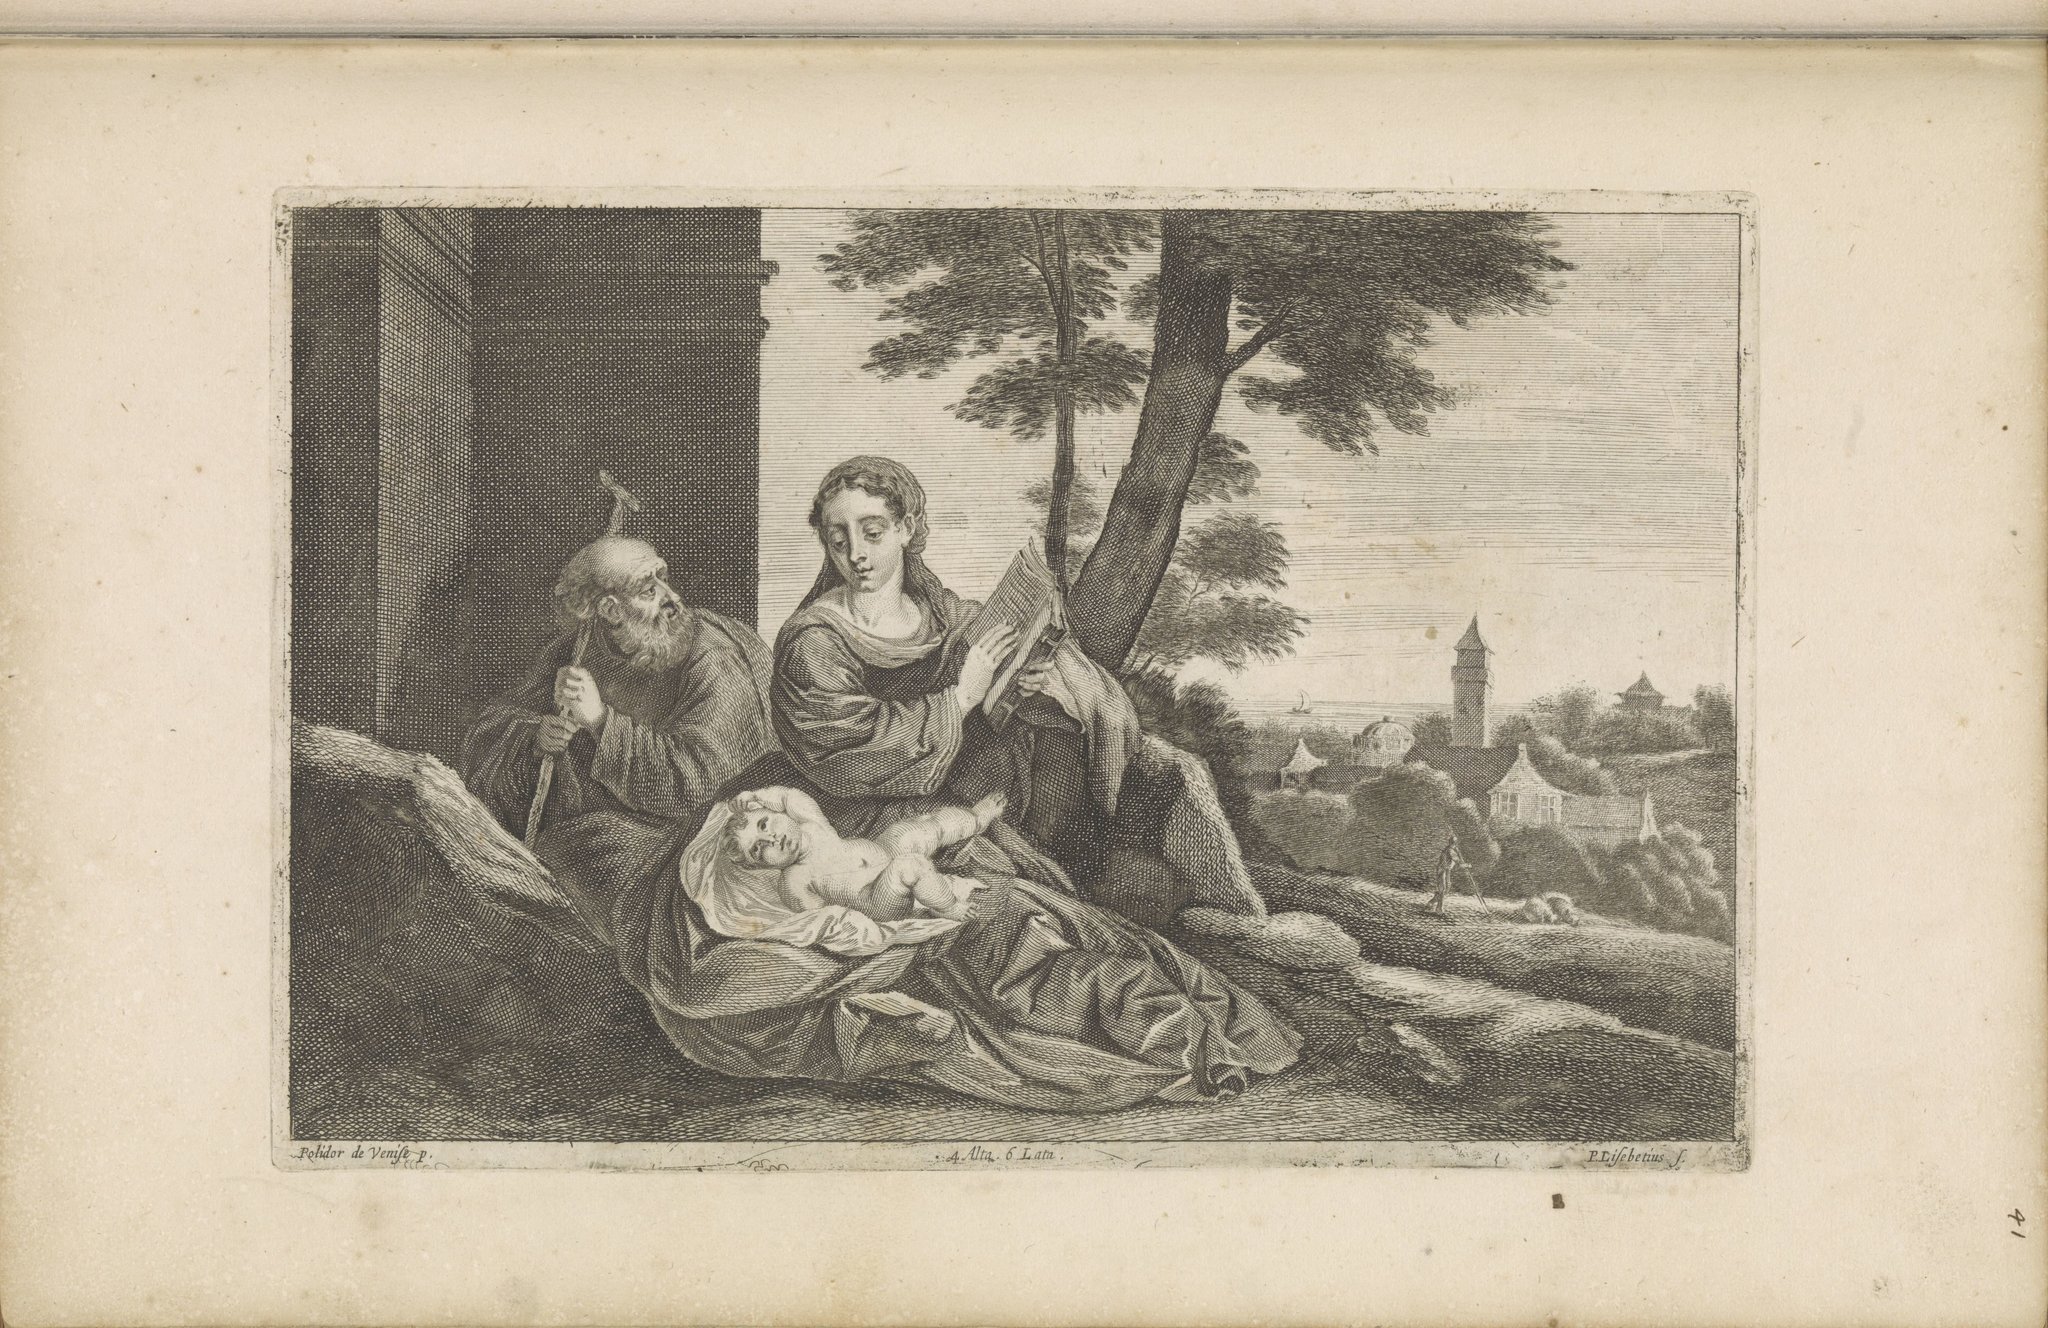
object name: album leaf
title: Heilige Familie in een landschap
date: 1660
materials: paper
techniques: engraving, etching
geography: venice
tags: reading, landscapes in the temperate zone, holy family (alone), 'trinitas terrestris'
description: David Teniers heeft waarschijnlijk van alle schilderijen uit de collectie van Leopold Willem van Oostenrijk een olieverfstudie op doek of paneel vervaardigd (zgn. pasticcio), die als voorbeeld voor de prentmakers diende. Het is niet altijd duidelijk of de pasticci door hem zijn gemaakt of door zijn atelier. Niet alle pasticci zijn overgeleverd.